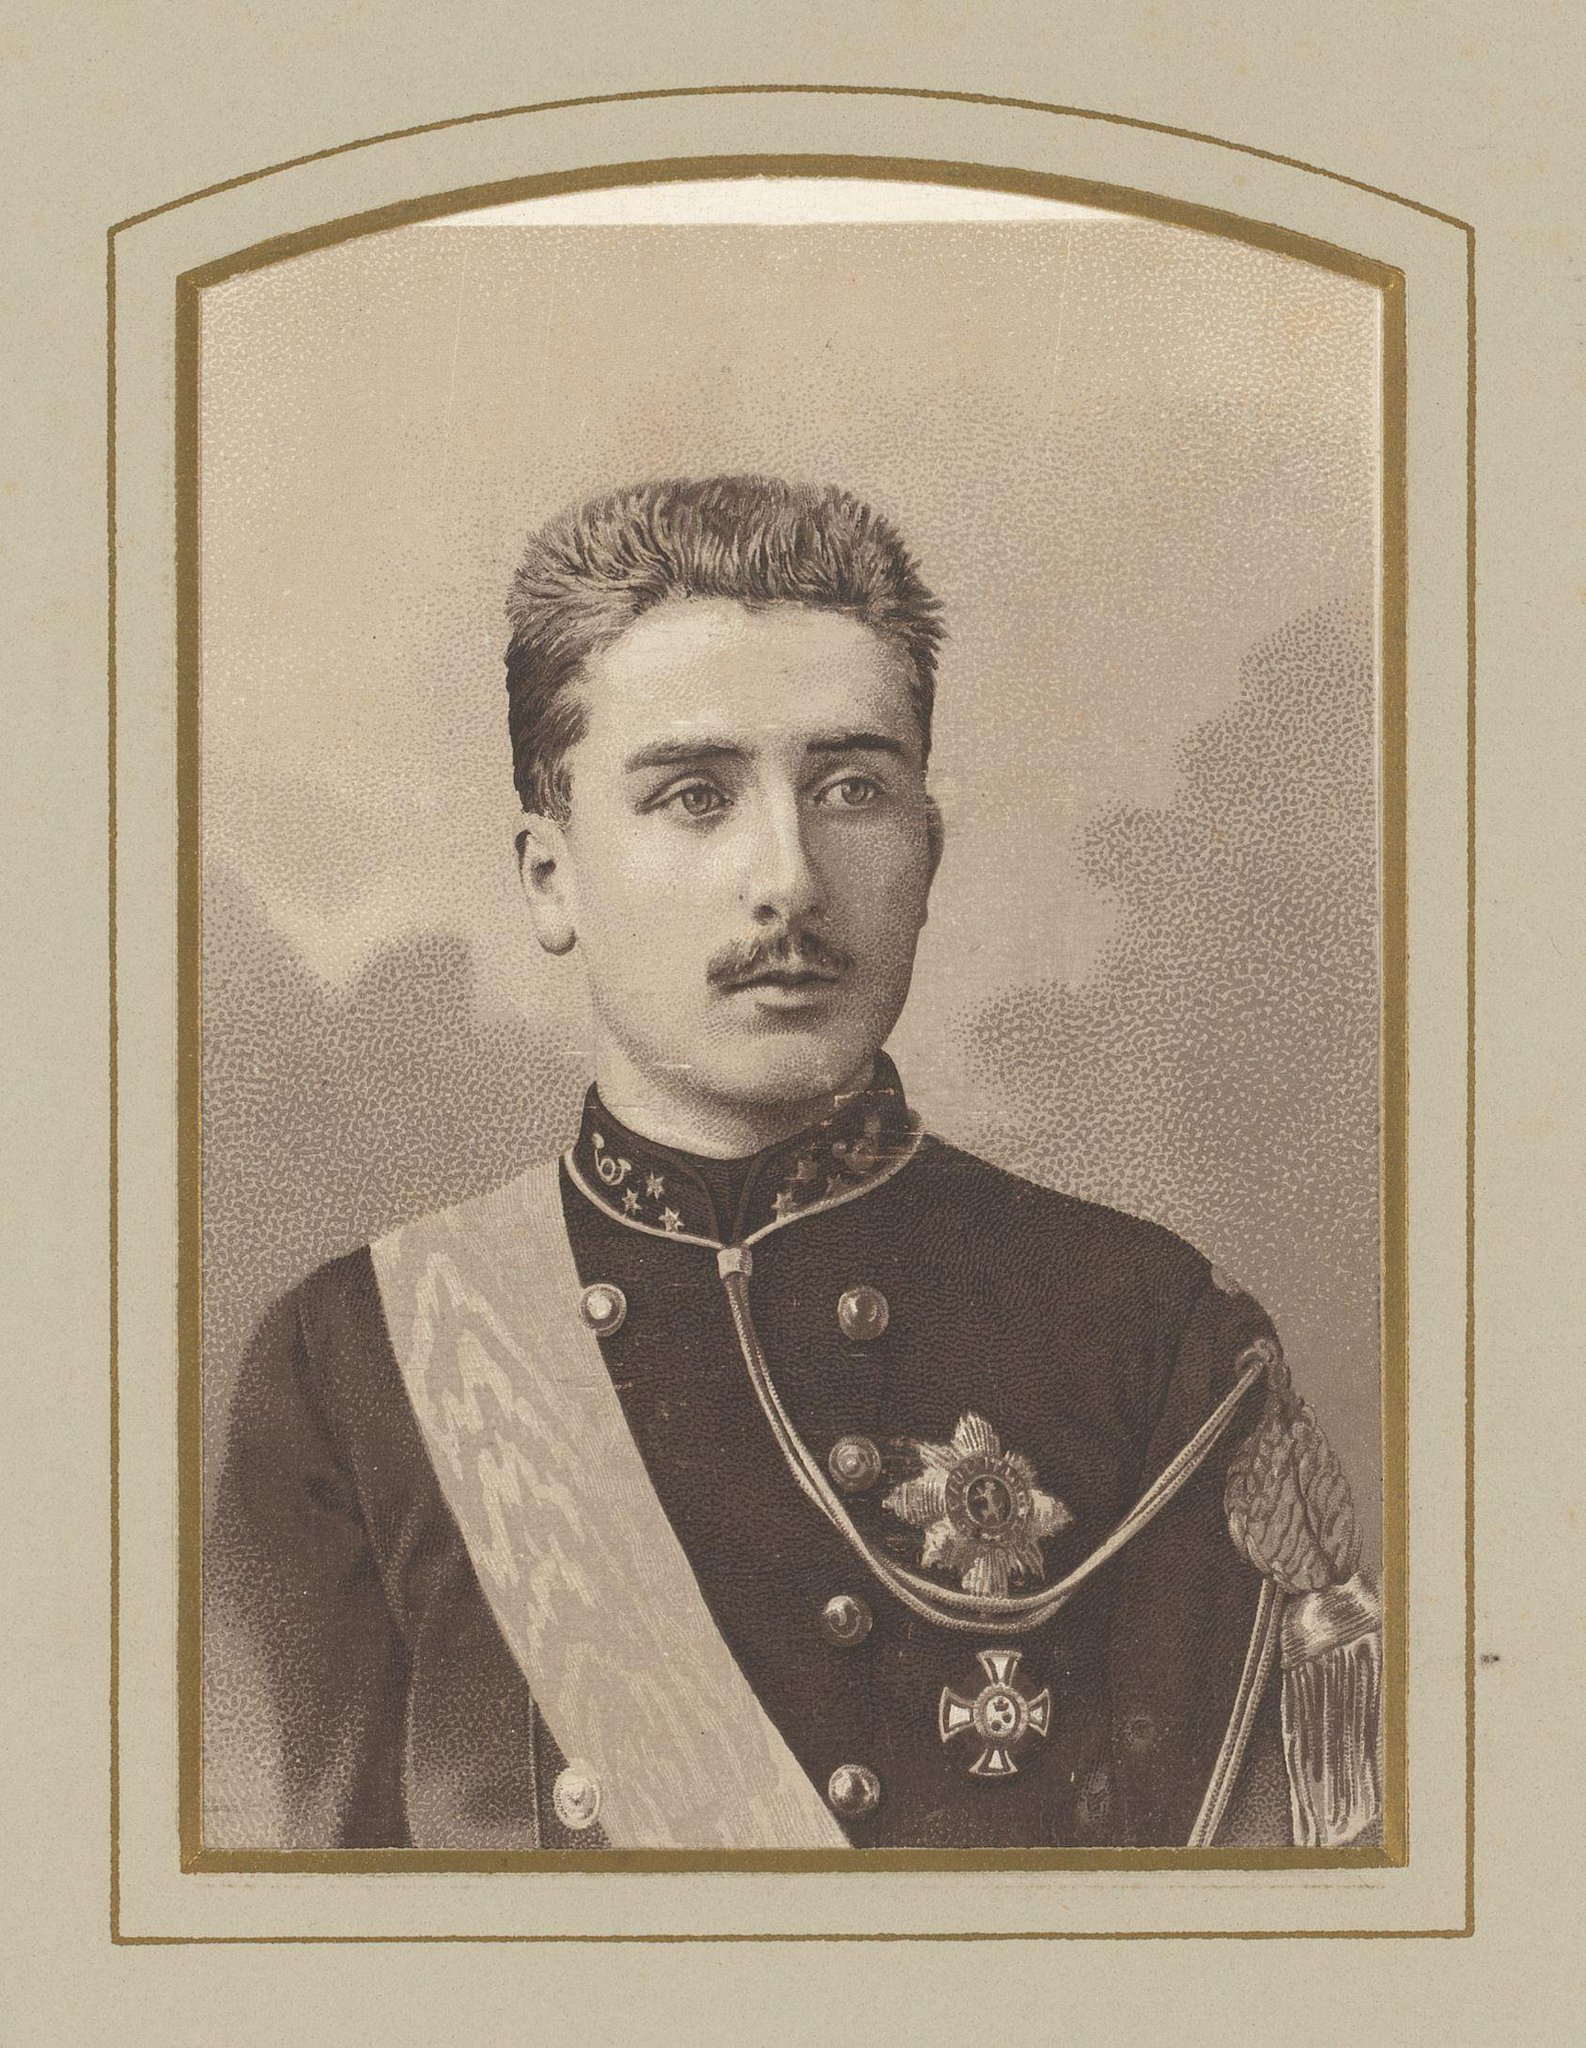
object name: album leaf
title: Portret van Boudewijn van België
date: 1870-1890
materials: paper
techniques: relief print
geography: brussels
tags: prince, historical persons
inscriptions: inscription: ‘S. A. R. le prince Baudouin-Léopold-Philippe-Marie/ Charles-Antoine-Joseph-Louis, né a Bruxelles, le/ 3 Juin 1869; décédé le 23 Janvier 1891.’